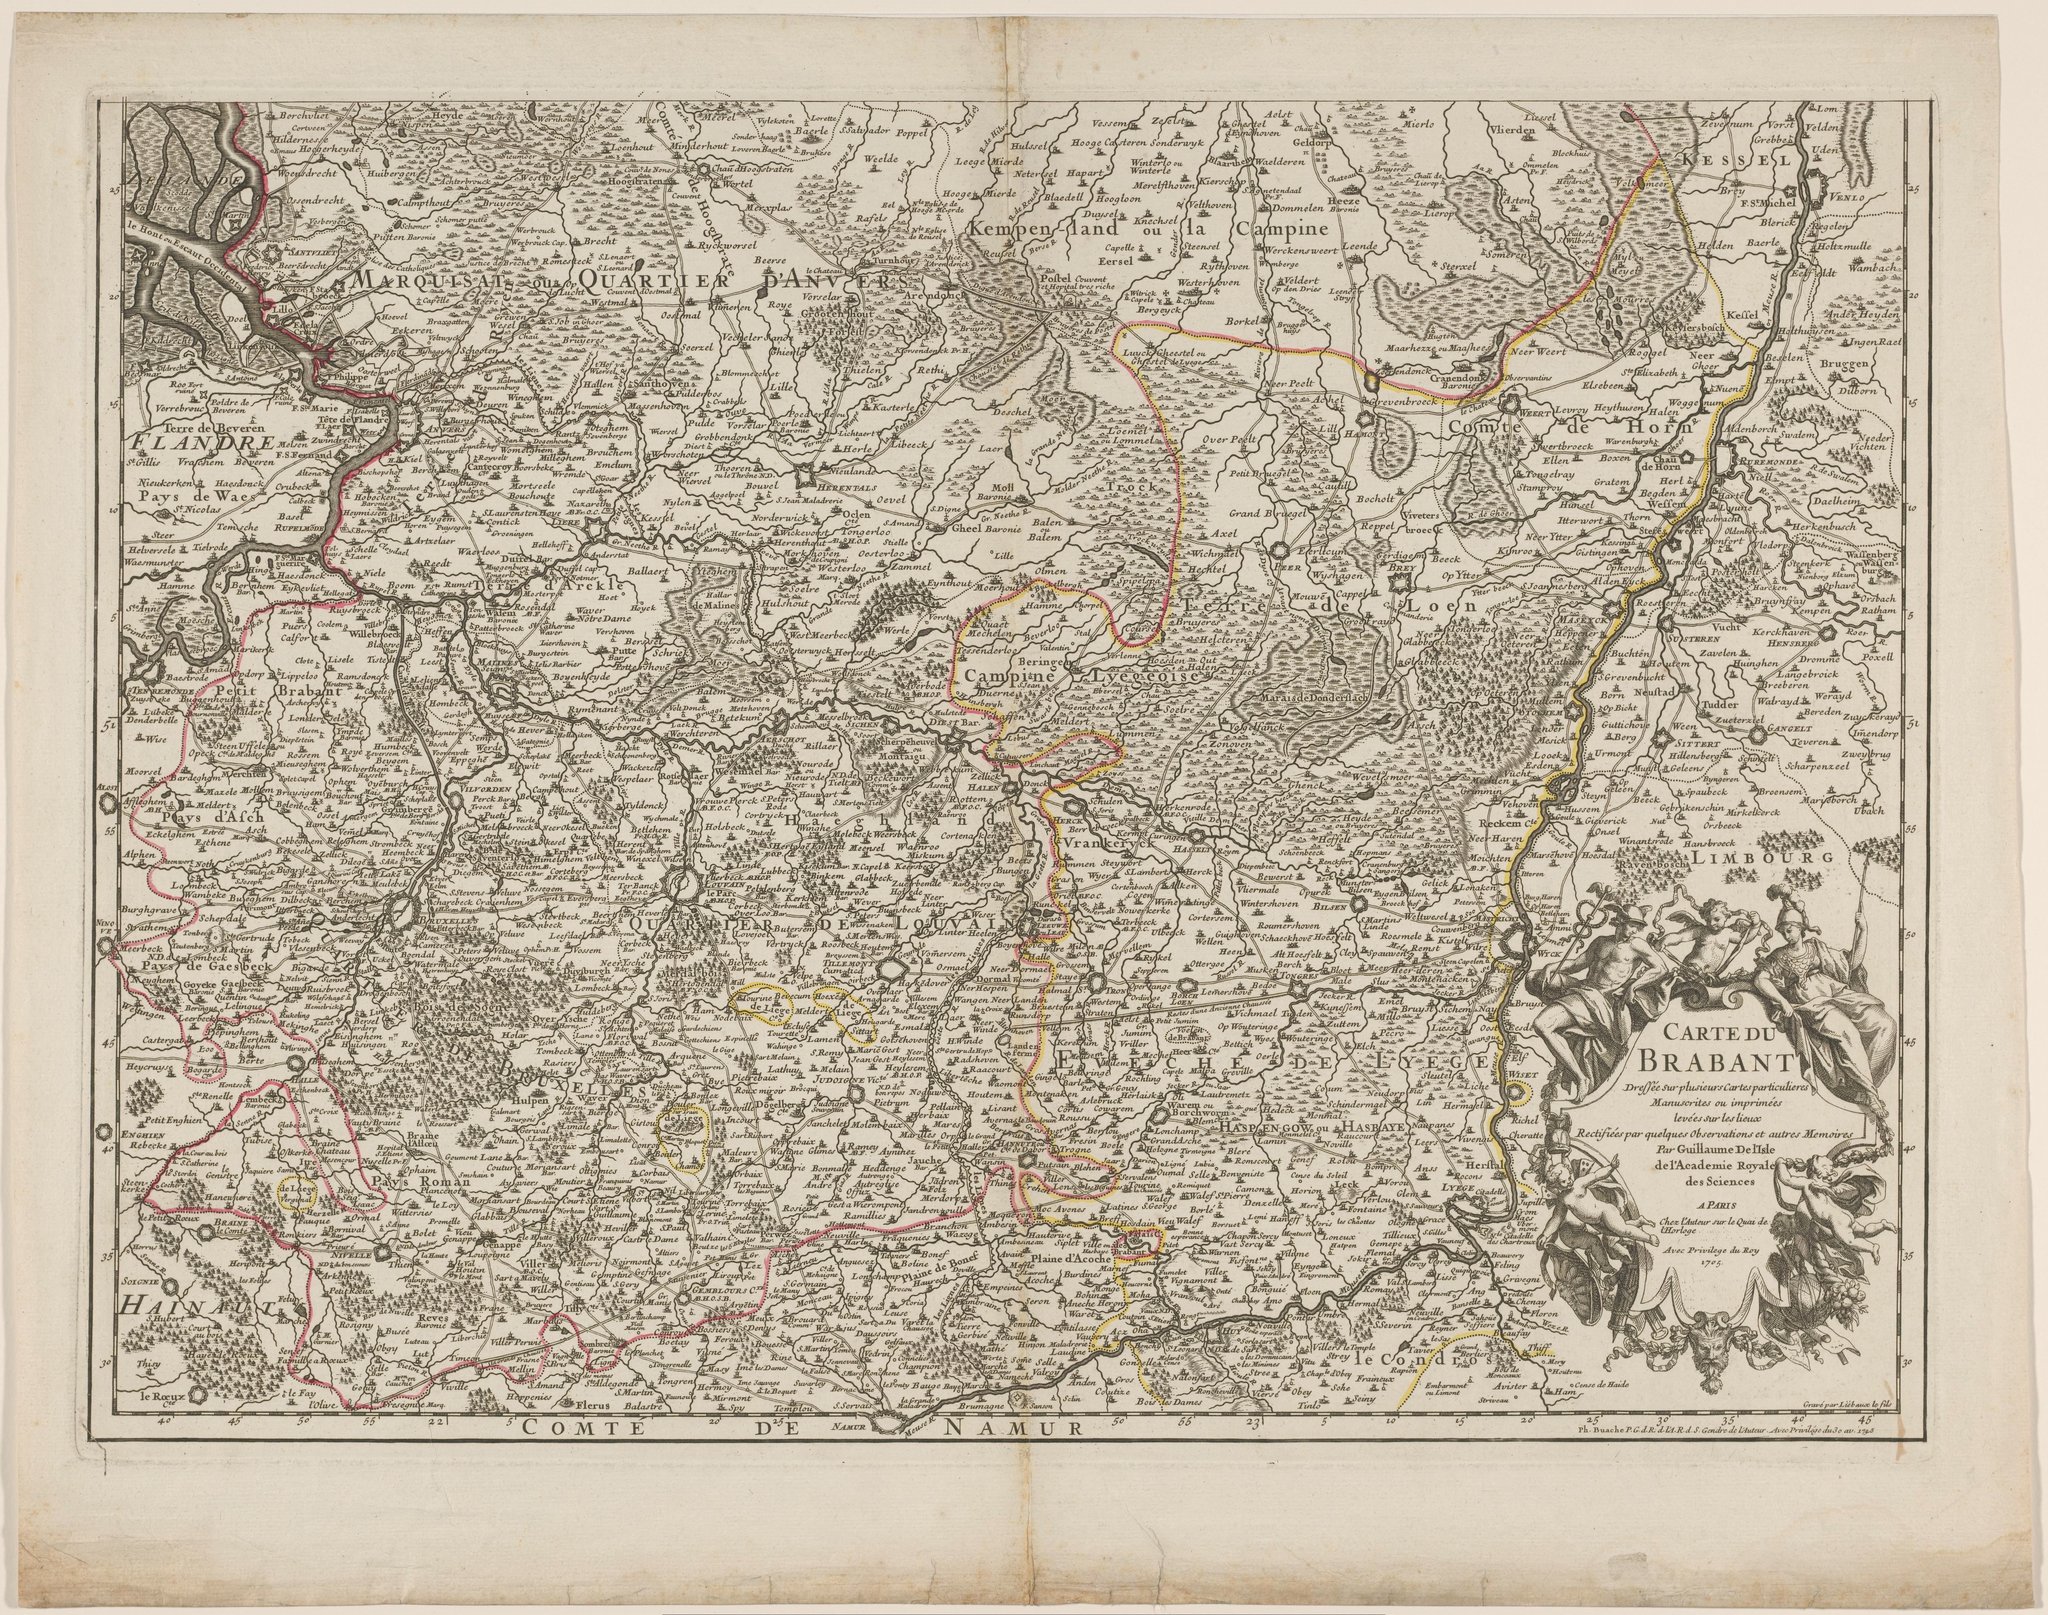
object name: map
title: Carte du Brabant dressée sur plusieurs cartes particulieres (...)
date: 1745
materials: paper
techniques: engraving, etching, hand coloring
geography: paris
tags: maps of separate countries or regions, (story of) minerva (pallas, athena), (story of) mercury (hermes), brabant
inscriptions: collector's mark: Lugt 2228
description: Onderste deel van een kaart van Brabant. Rechtsonder de titelcartouche met Minerva, Mercurius en drie putti. De kaart is voorzien van een gradenverdeling langs de randen.